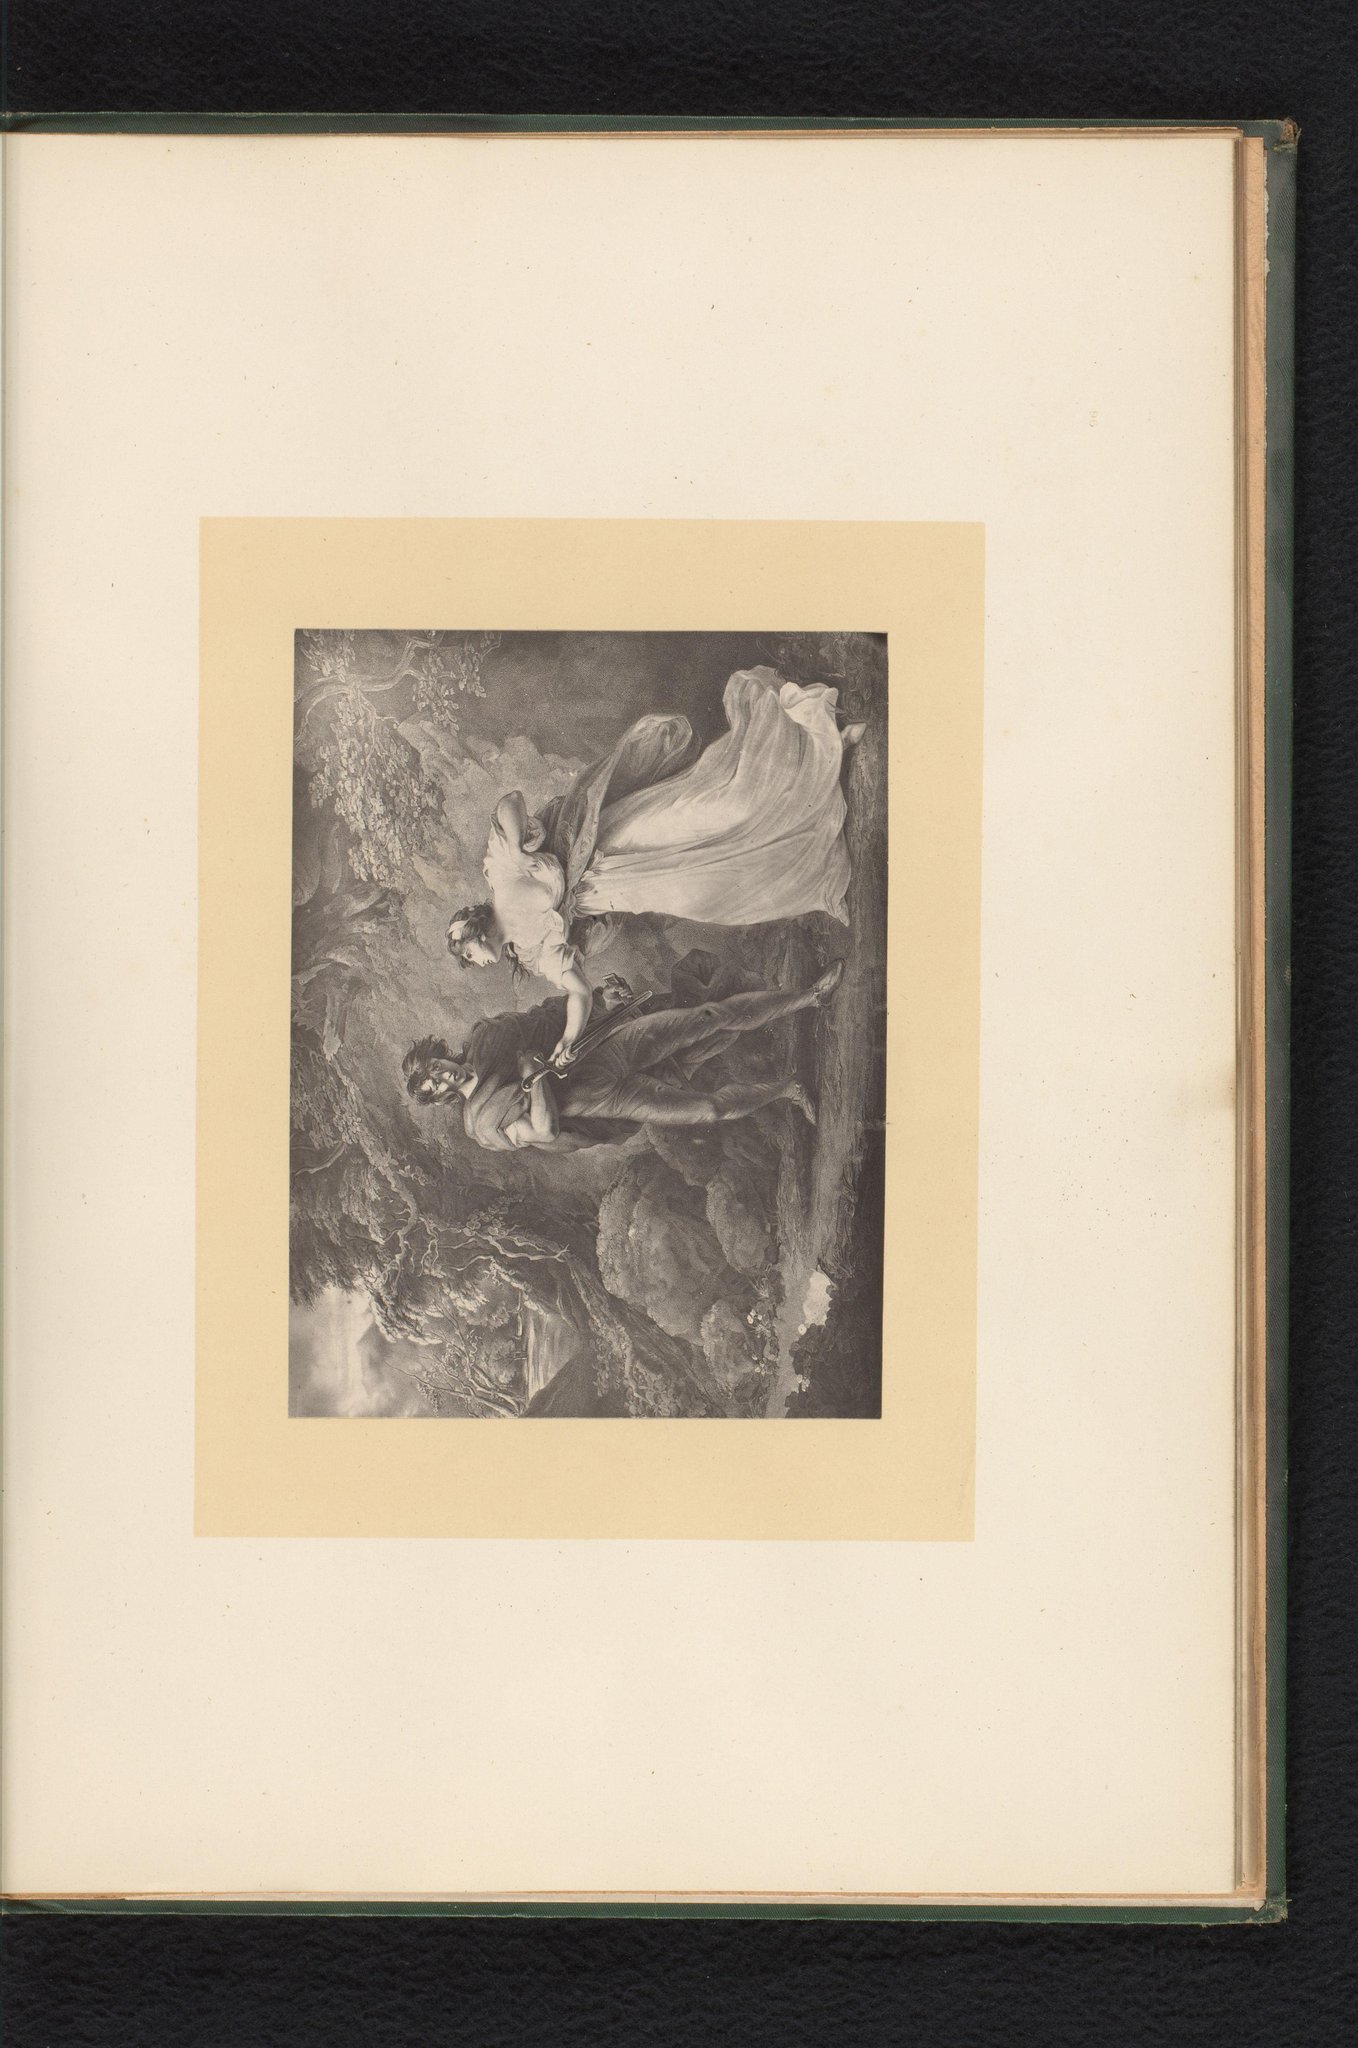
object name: page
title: Reproductie van een gravure naar een schilderij van een scène uit Cymbeline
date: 1874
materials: paper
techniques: woodburytype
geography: london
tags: (scenes from) specific works of literature: shakespeare, cymbeline